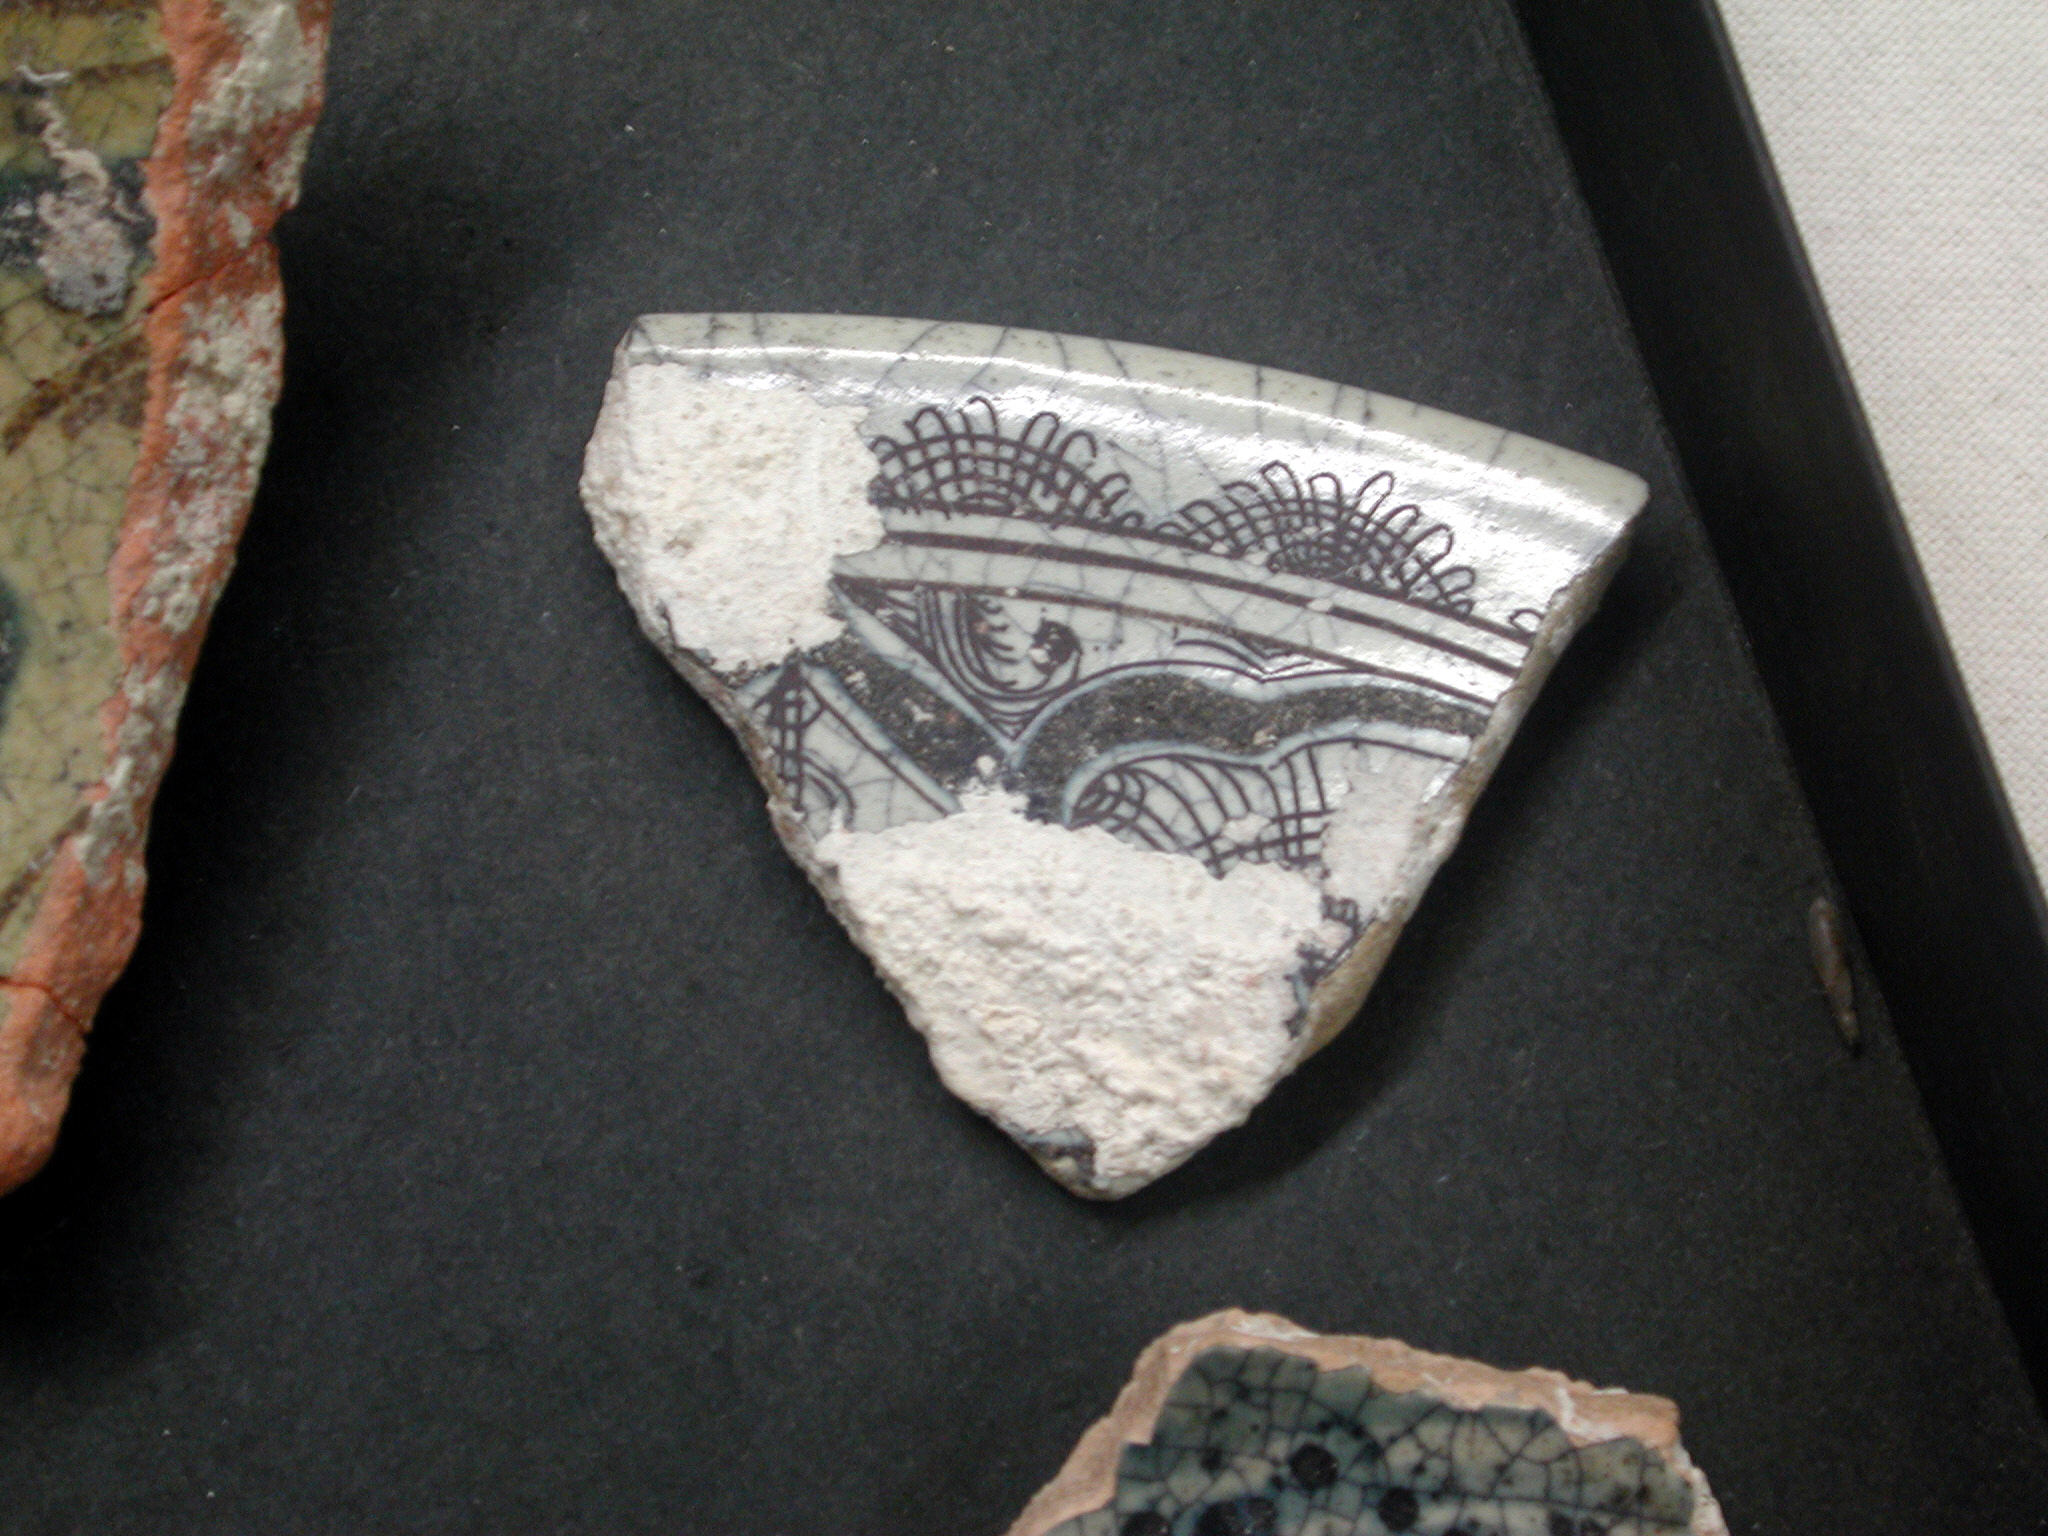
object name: fragment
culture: mexican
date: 1601-1650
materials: earthenware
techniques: glazing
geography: mexico